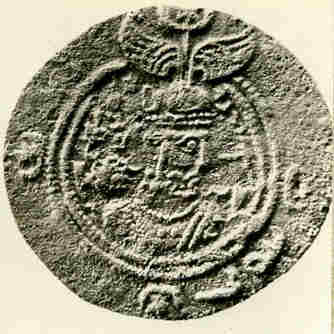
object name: coin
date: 560-628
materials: copper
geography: iran